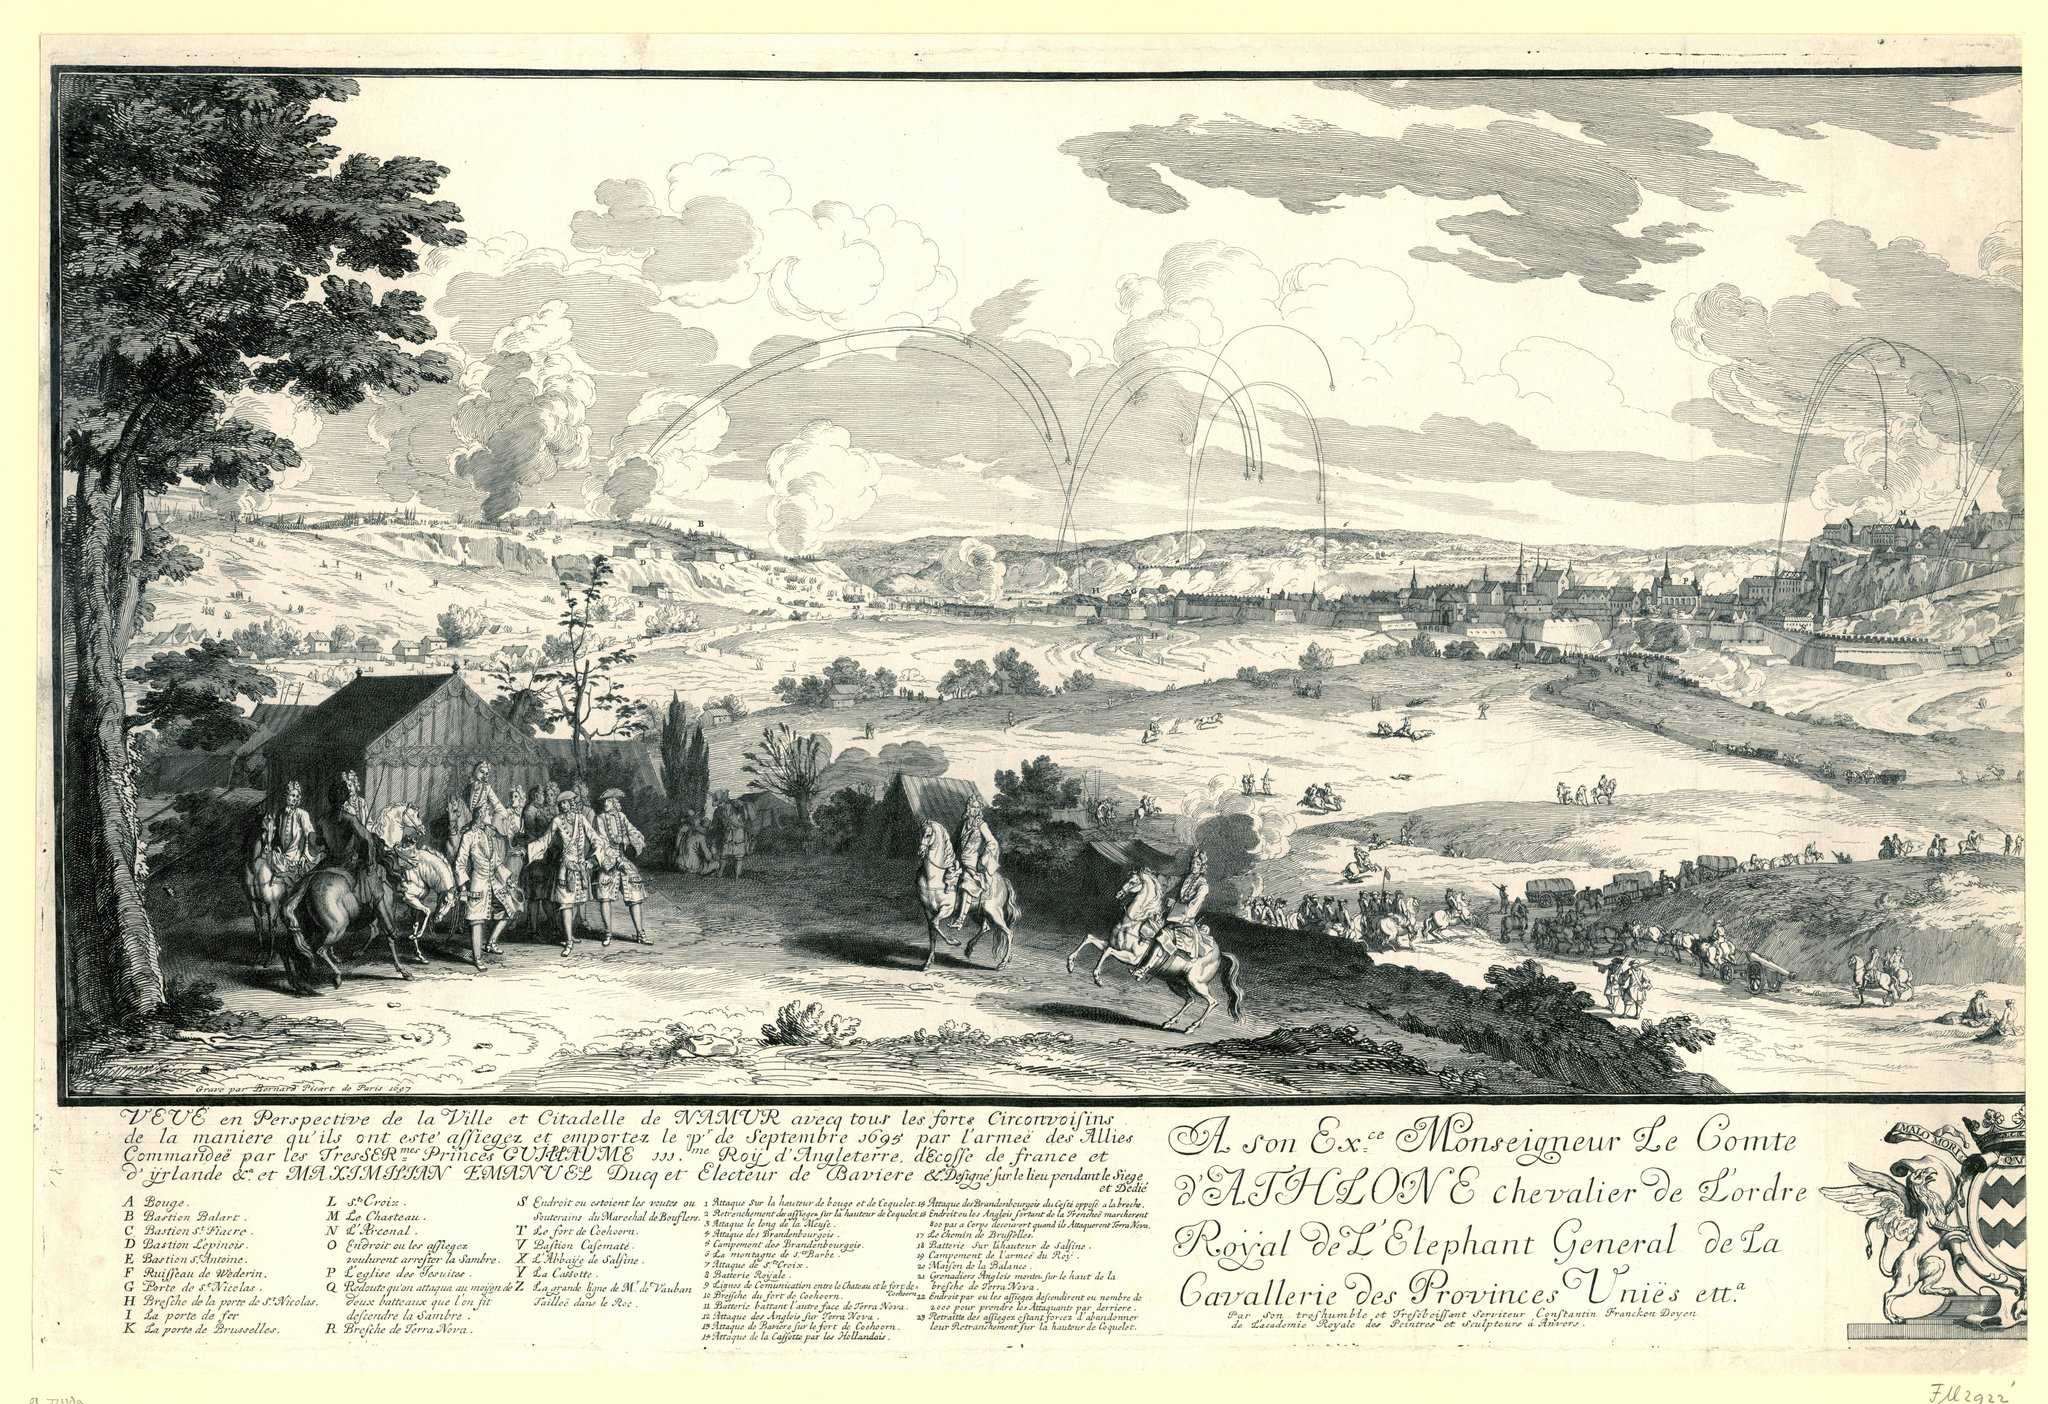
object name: print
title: Gezicht op het beleg van Namen (linkerhelft), 1695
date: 1697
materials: paper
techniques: etching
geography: northern netherlands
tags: the hague, william iii (prince of orange and king of england, scotland, and ireland), maximiliaan ii emanuel (keurvorst van beieren), siege, position war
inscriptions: date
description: Linkerhelft van een grote voorstelling in twee delen van het beleg van Namen in 1695 door de Geallieerden onder koning Willem III en de keurvorst van Beieren. Op de voorgrond links de bevelhebbers voor een legertent. In het onderschrift de opdracht en de legenda A-Z en 1-23 in het Frans. Zie voor het rechterdeel met Engelse titel de prent met objectnummer RP-P-OB-77.338B.